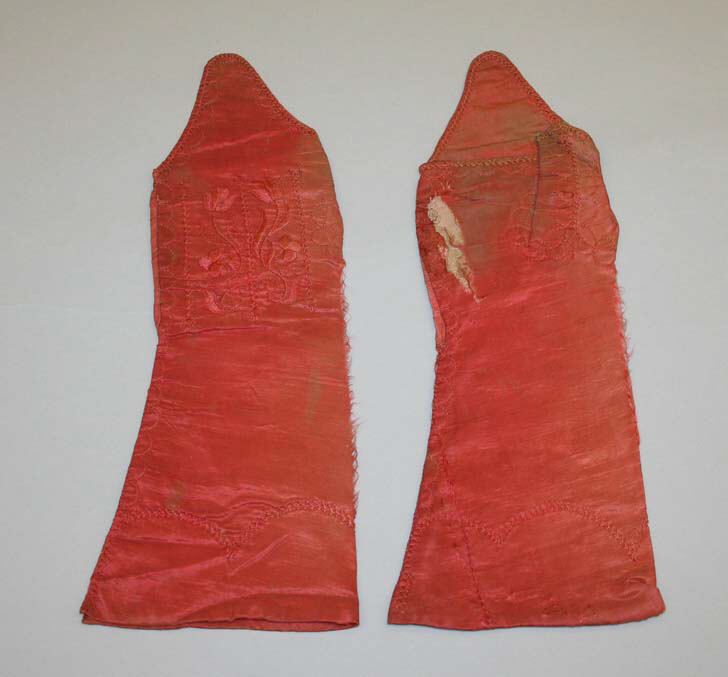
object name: mitt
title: Mitts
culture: european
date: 1701-1800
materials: silk